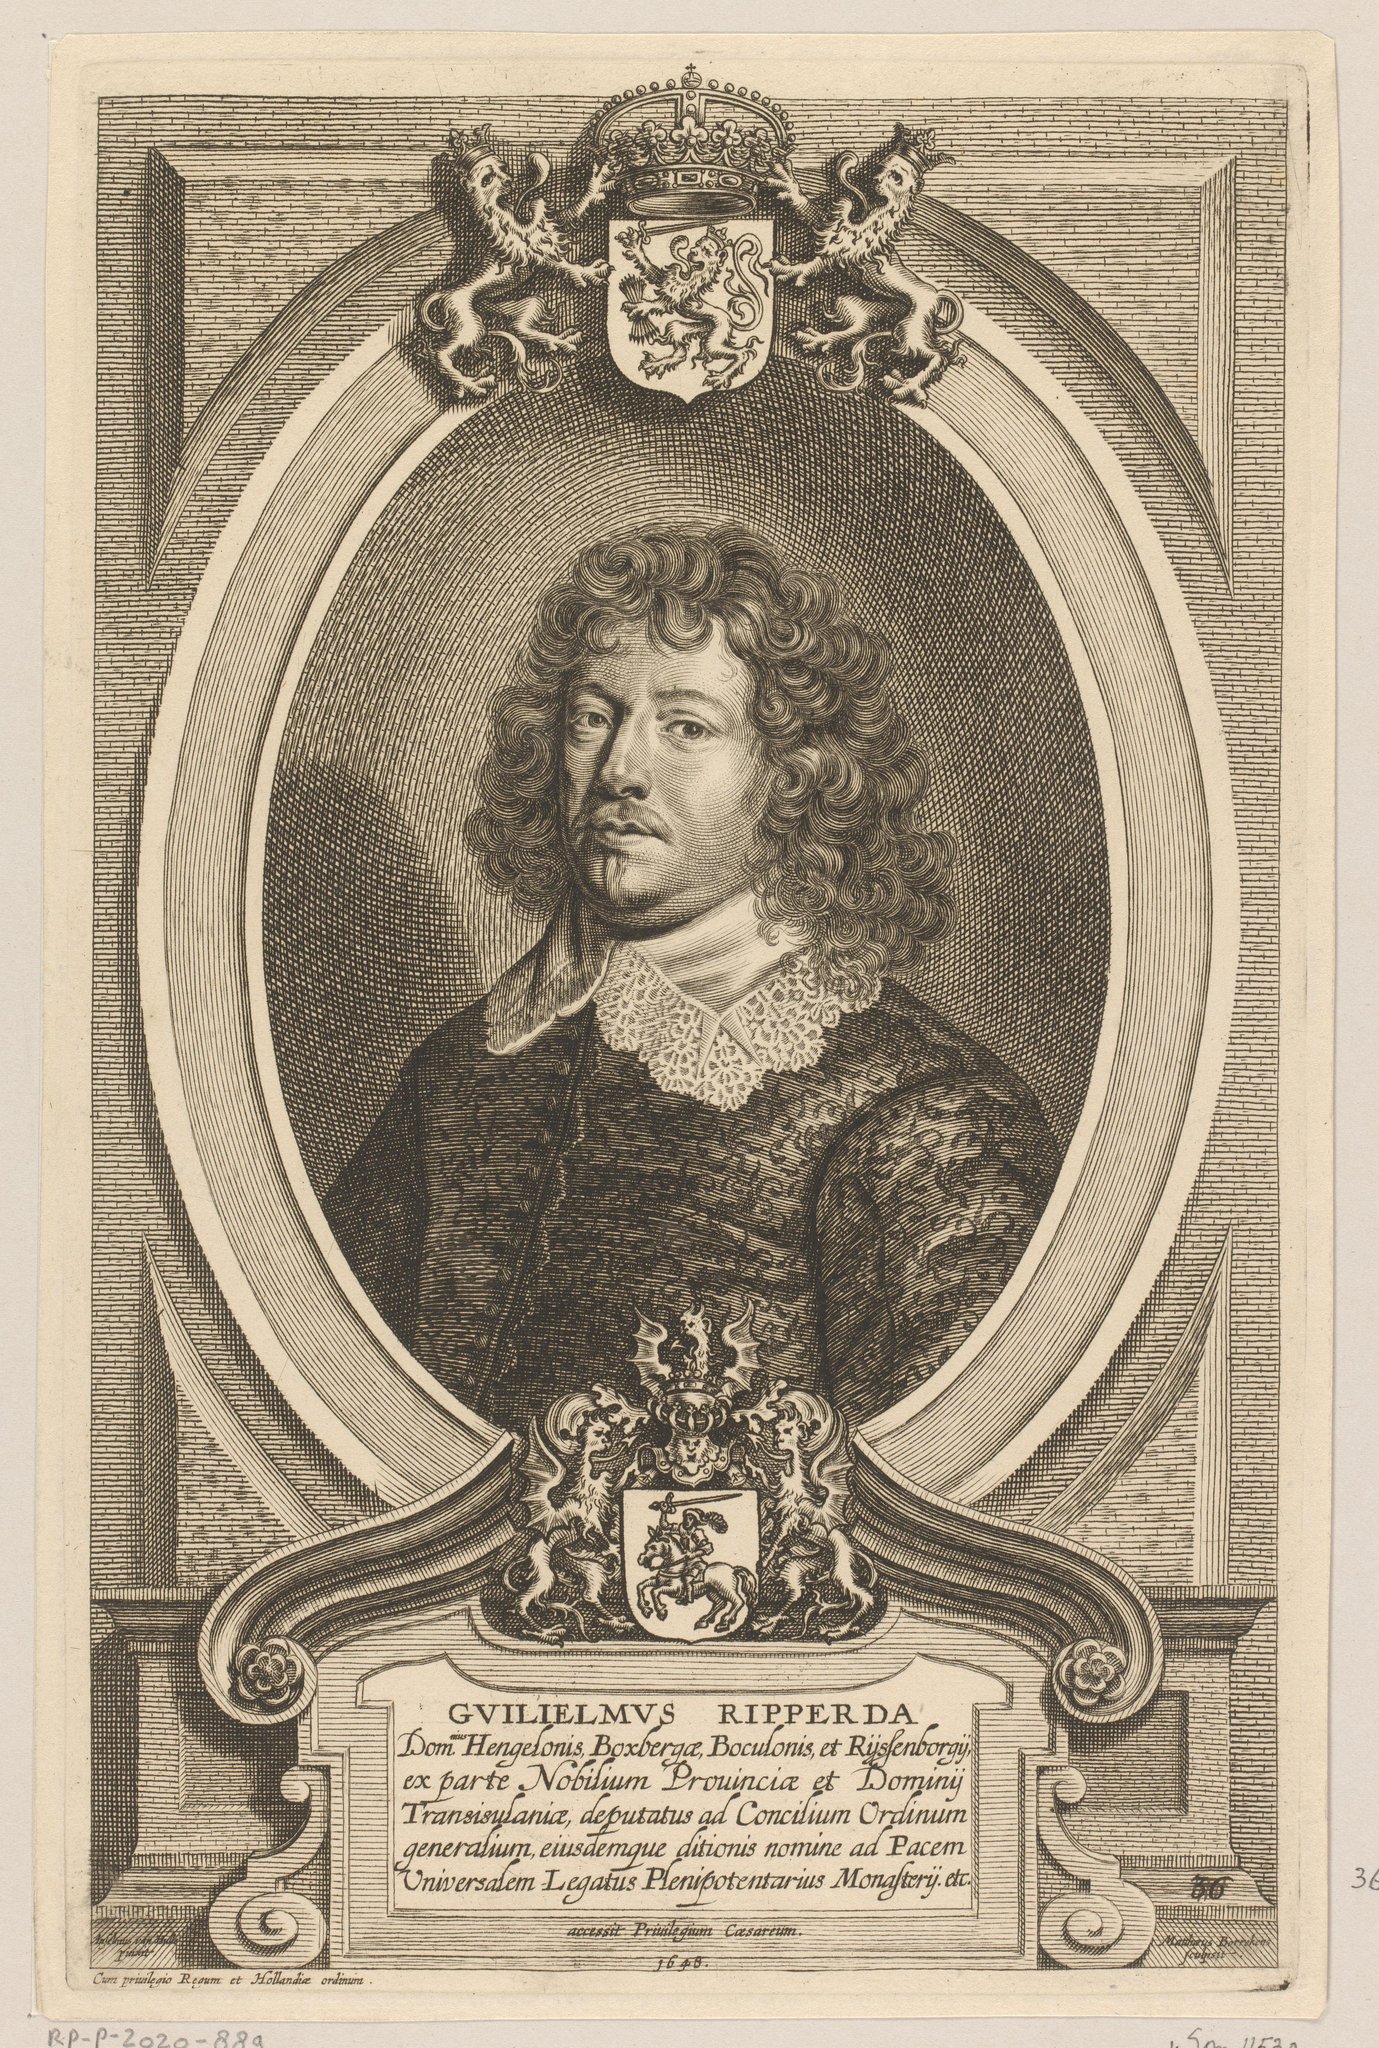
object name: print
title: Guilielmus Ripperda. Dominus Hengelonis, Boxbergae, Boculonis et Rijssenborgij ex parte (...)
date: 1697-1717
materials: paper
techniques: engraving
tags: historical persons, diplomacy, diplomat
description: Prent is gebruikt in verschillende series. De huidige staat is gebruikt in de hieronder vermelde serie en uitgaven (6), (7) en (8). (1)'Icones legatorum (...)', uitgegeven door Daniel Middeler in 1648 in Antwerpen. (2)‘Legati Celeberrimi’, uitgegeven door Daniel Middeler in 1648 in Antwerpen. (3)‘Legati Celeberrimi’, waarschijnlijk uitgegeven in 1651, maar opnieuw met de vermelding door Daniel Middeler in 1648 in Antwerpen. (4)‘Legati Celeberrimi', waarschijnlijk uitgegeven in 1658, maar opnieuw met de vermelding door Daniel Middeler in 1648 in Antwerpen. (5) 'Pacificatores orbis Christiani, sive icones principum, ducum et legatorum, qui Monasterii atque Osnabrugae (...)', uitgegeven door Pieter van der Slaart in 1696 in Rotterdam. (6) 'Pacificatores orbis Christiani, sive icones principum, ducum et legatorum, qui Monasterii atque Osnabrugae (...)', uitgegeven door Pieter van der Slaart in 1697 in Rotterdam. (7) 'Pacificatores orbis Christiani, sive icones principum, ducum et legatorum, qui Monasterii atque Osnabrugae (...)', waarschijnlijk uitgegeven circa 1713, maar opnieuw met vermelding van Pieter van der Slaart in 1697 in Rotterdam. De platen in deze uitgave zijn voor het eerst genummerd. (8) 'Les hommes illustres qui ont vécu dans le XXIIe siècle (...)', uitgegeven door David Mortier in 1717 in Rotterdam. Zie documentatie. Mogelijk zijn er nog meerdere uitgaven en staten van deze prent.